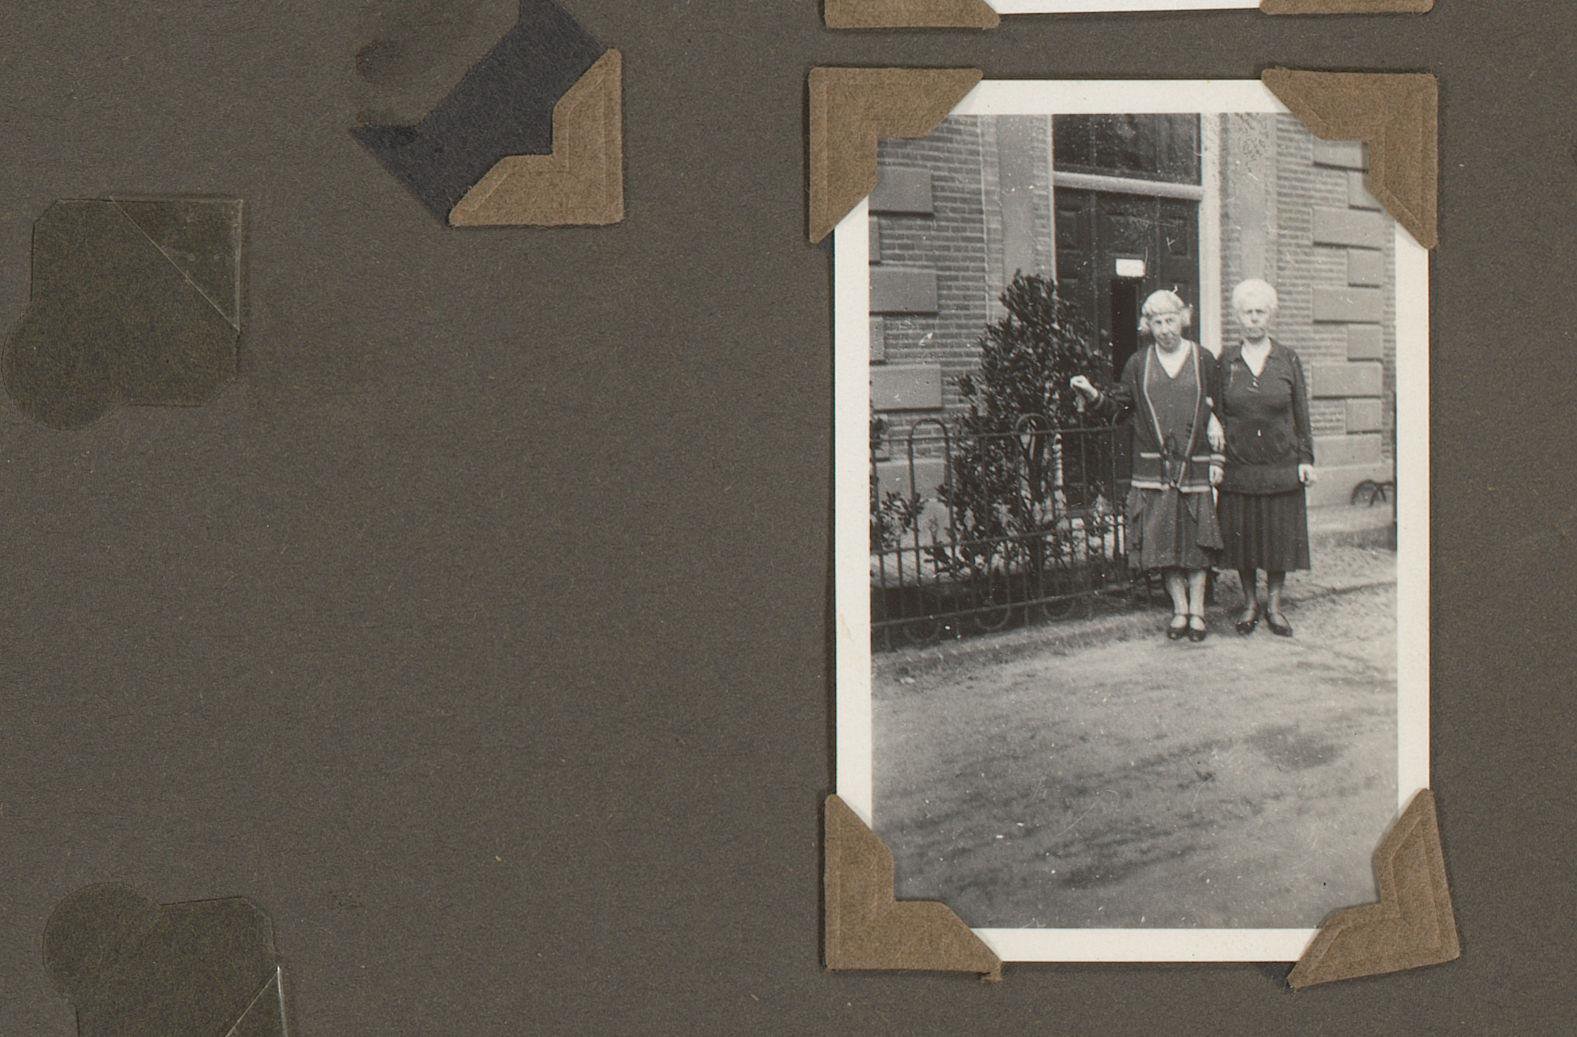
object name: album leaf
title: Twee vrouwen staande voor een hek, gearmd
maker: Anonymous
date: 1920-1930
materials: photographic support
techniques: gelatin silver print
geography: netherlands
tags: urban housing, historical persons, adult woman (+ two persons)